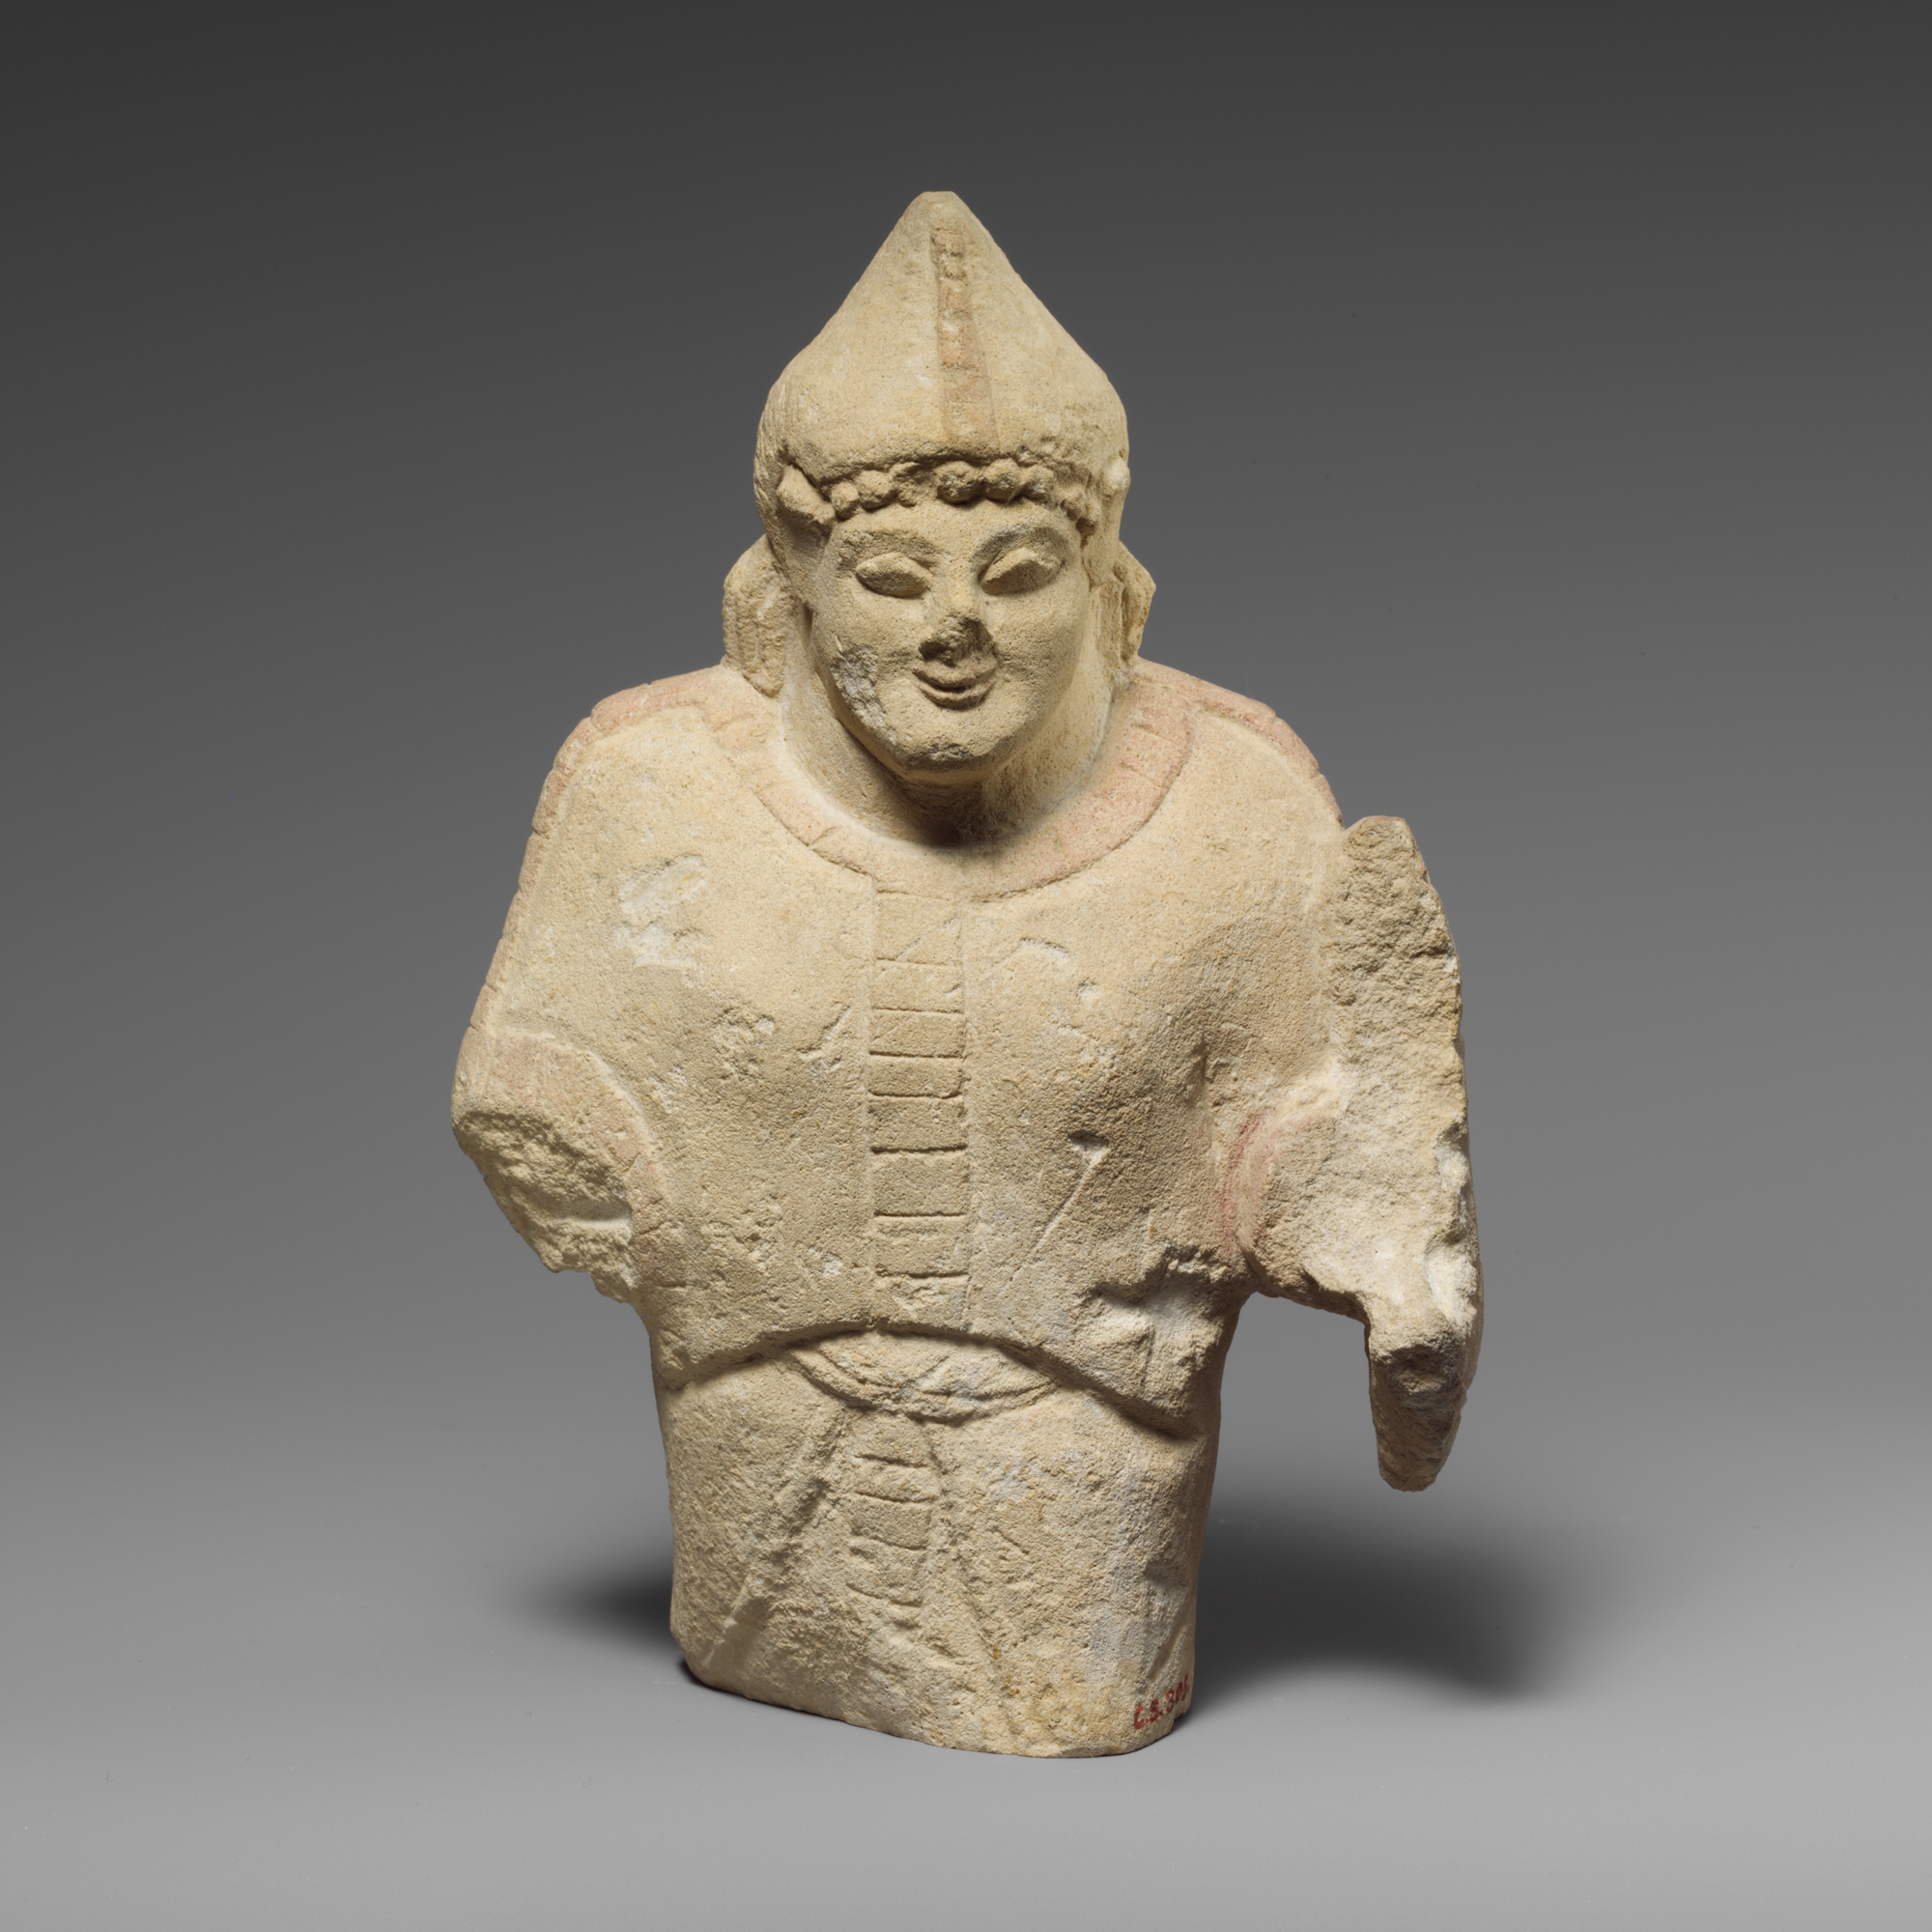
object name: statuette of a warrior in oriental garb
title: Limestone statuette of a warrior holding a shield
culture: cypriot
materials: limestone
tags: helmets,men,warriors